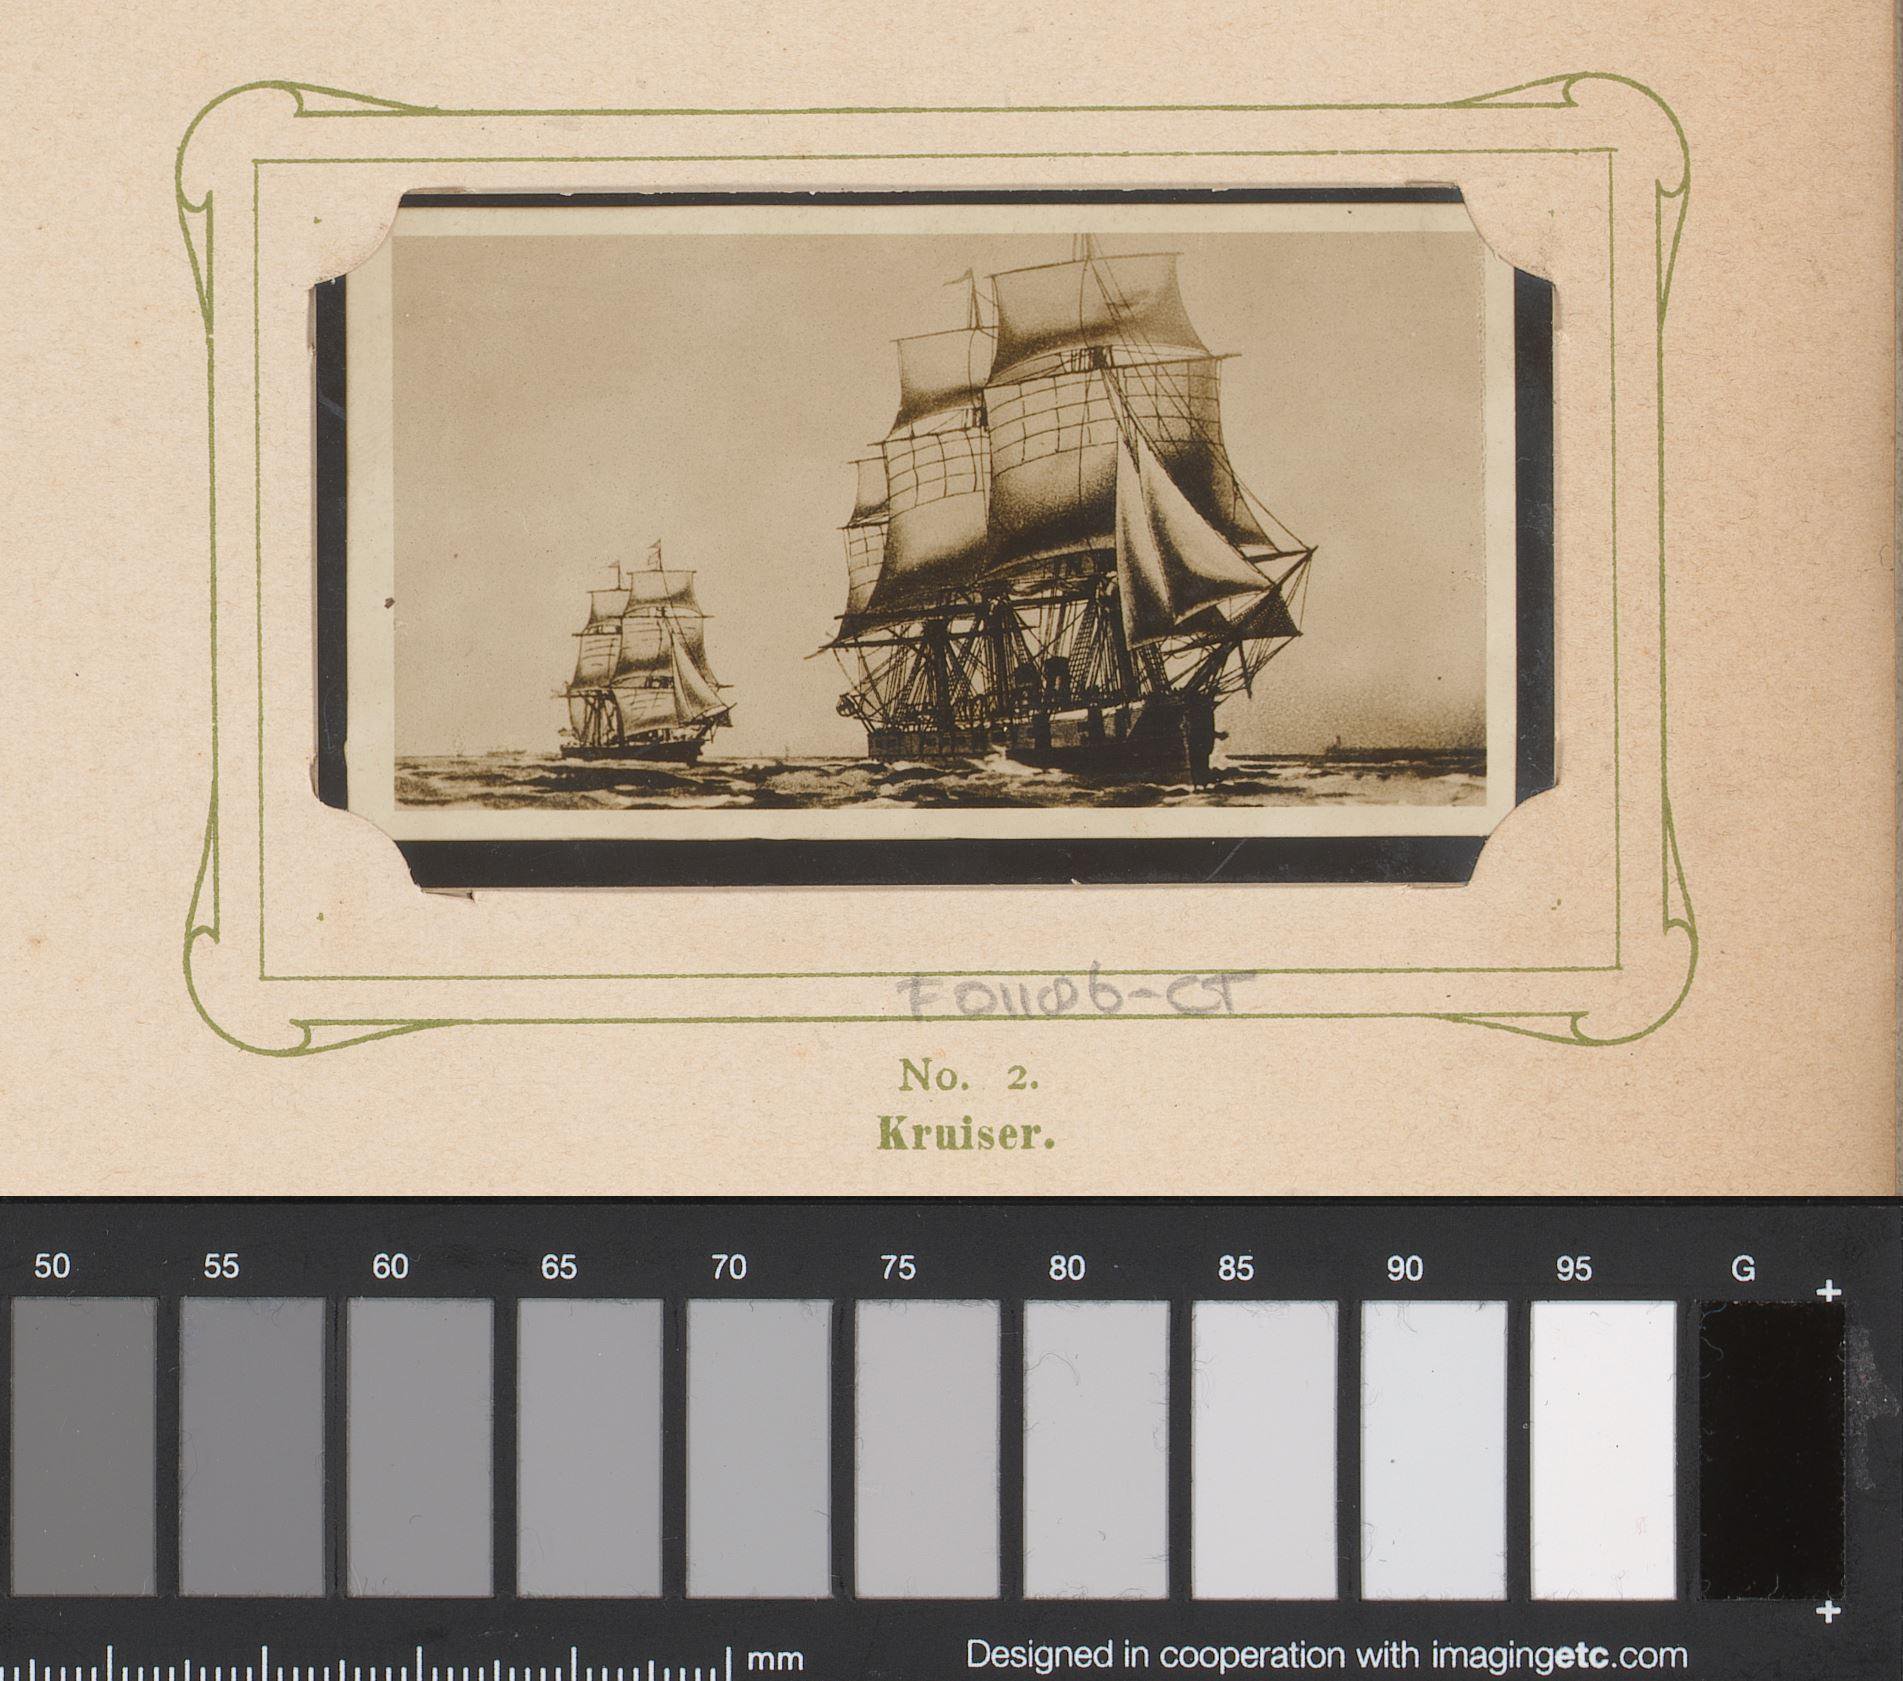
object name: photograph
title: Fotoreproductie van een schilderij van twee kruisers te water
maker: Anonymous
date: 1904-1905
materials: photographic support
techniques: gelatin silver print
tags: warfare; military affairs (+ sailing-ships)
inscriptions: inscription: ‘No. 2./ Kruiser.’